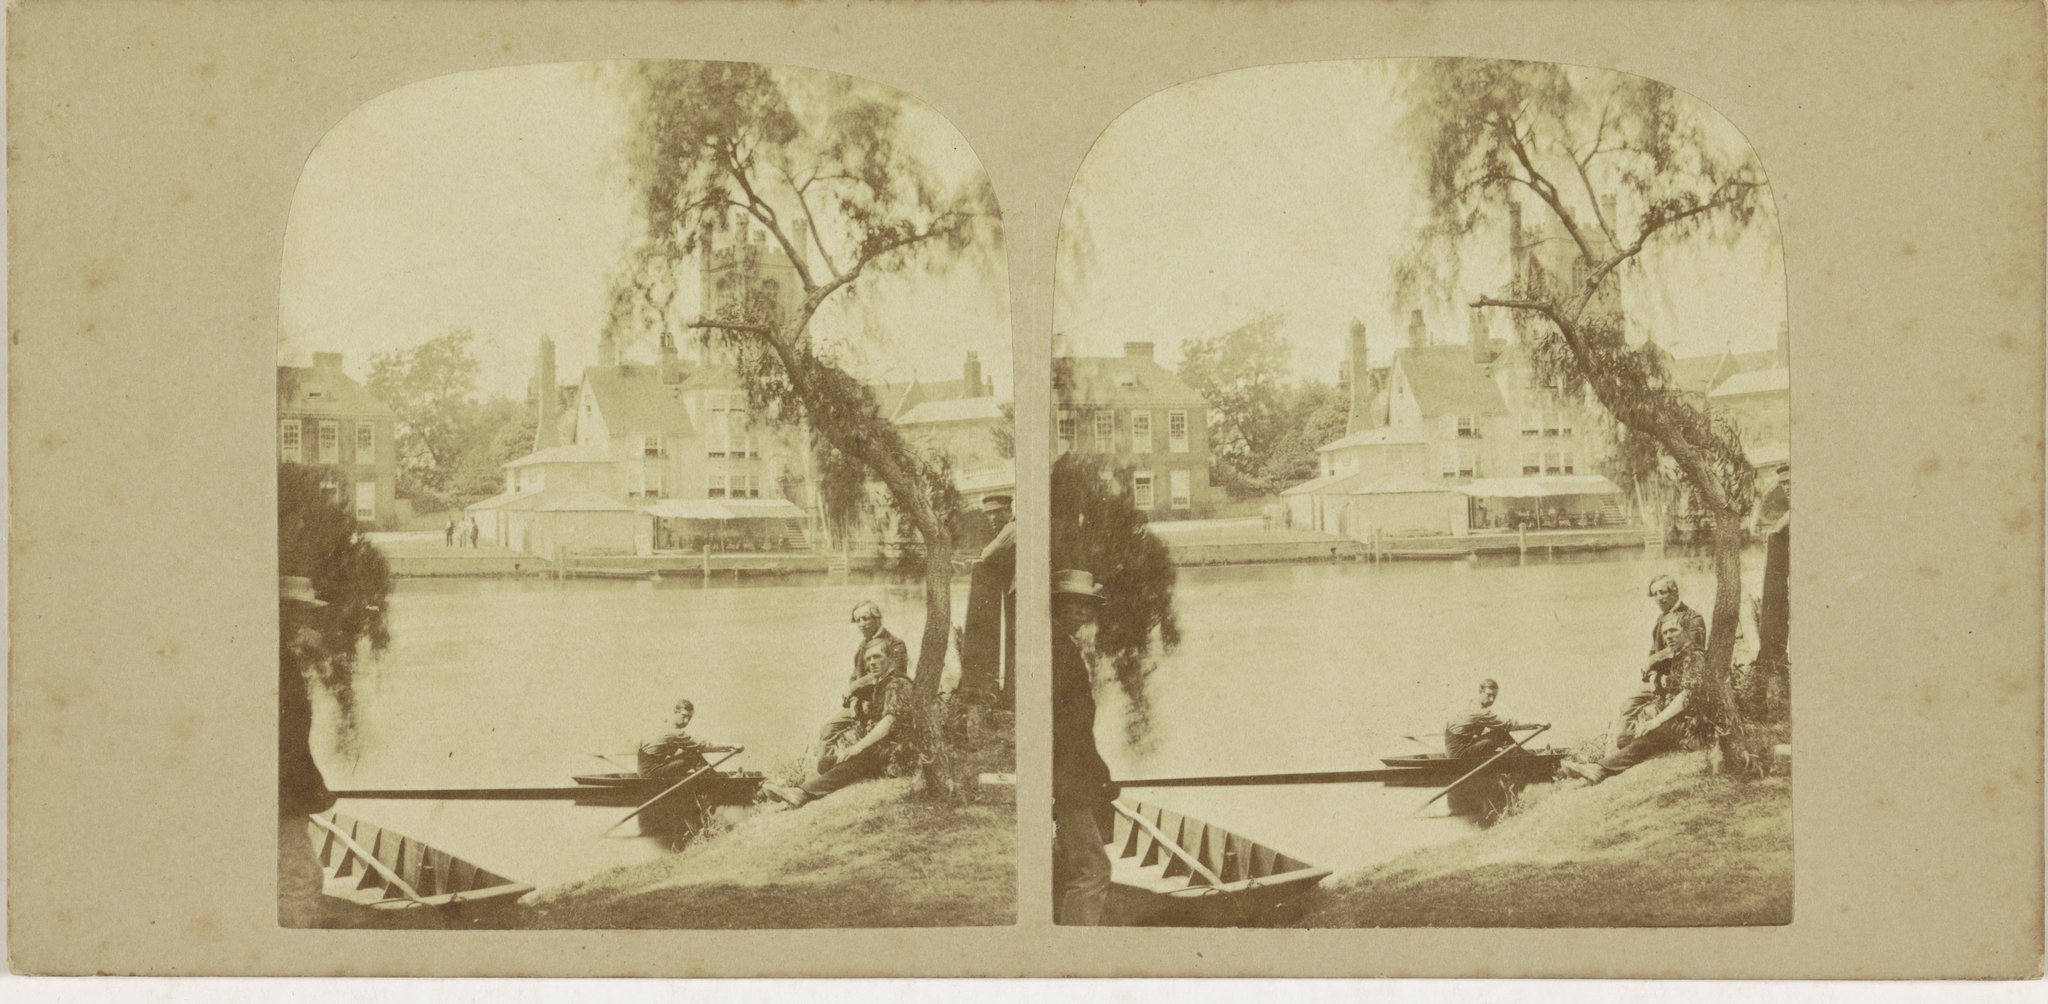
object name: stereograph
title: Gezicht op de Henley Regatta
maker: Anonymous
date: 1858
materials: cardboard, paper, photographic support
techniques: albumen print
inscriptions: label: ‘View at Henley Regatta, 1858.’, name: ‘H. Ameschot.’, inscription: ‘N.° 15.’